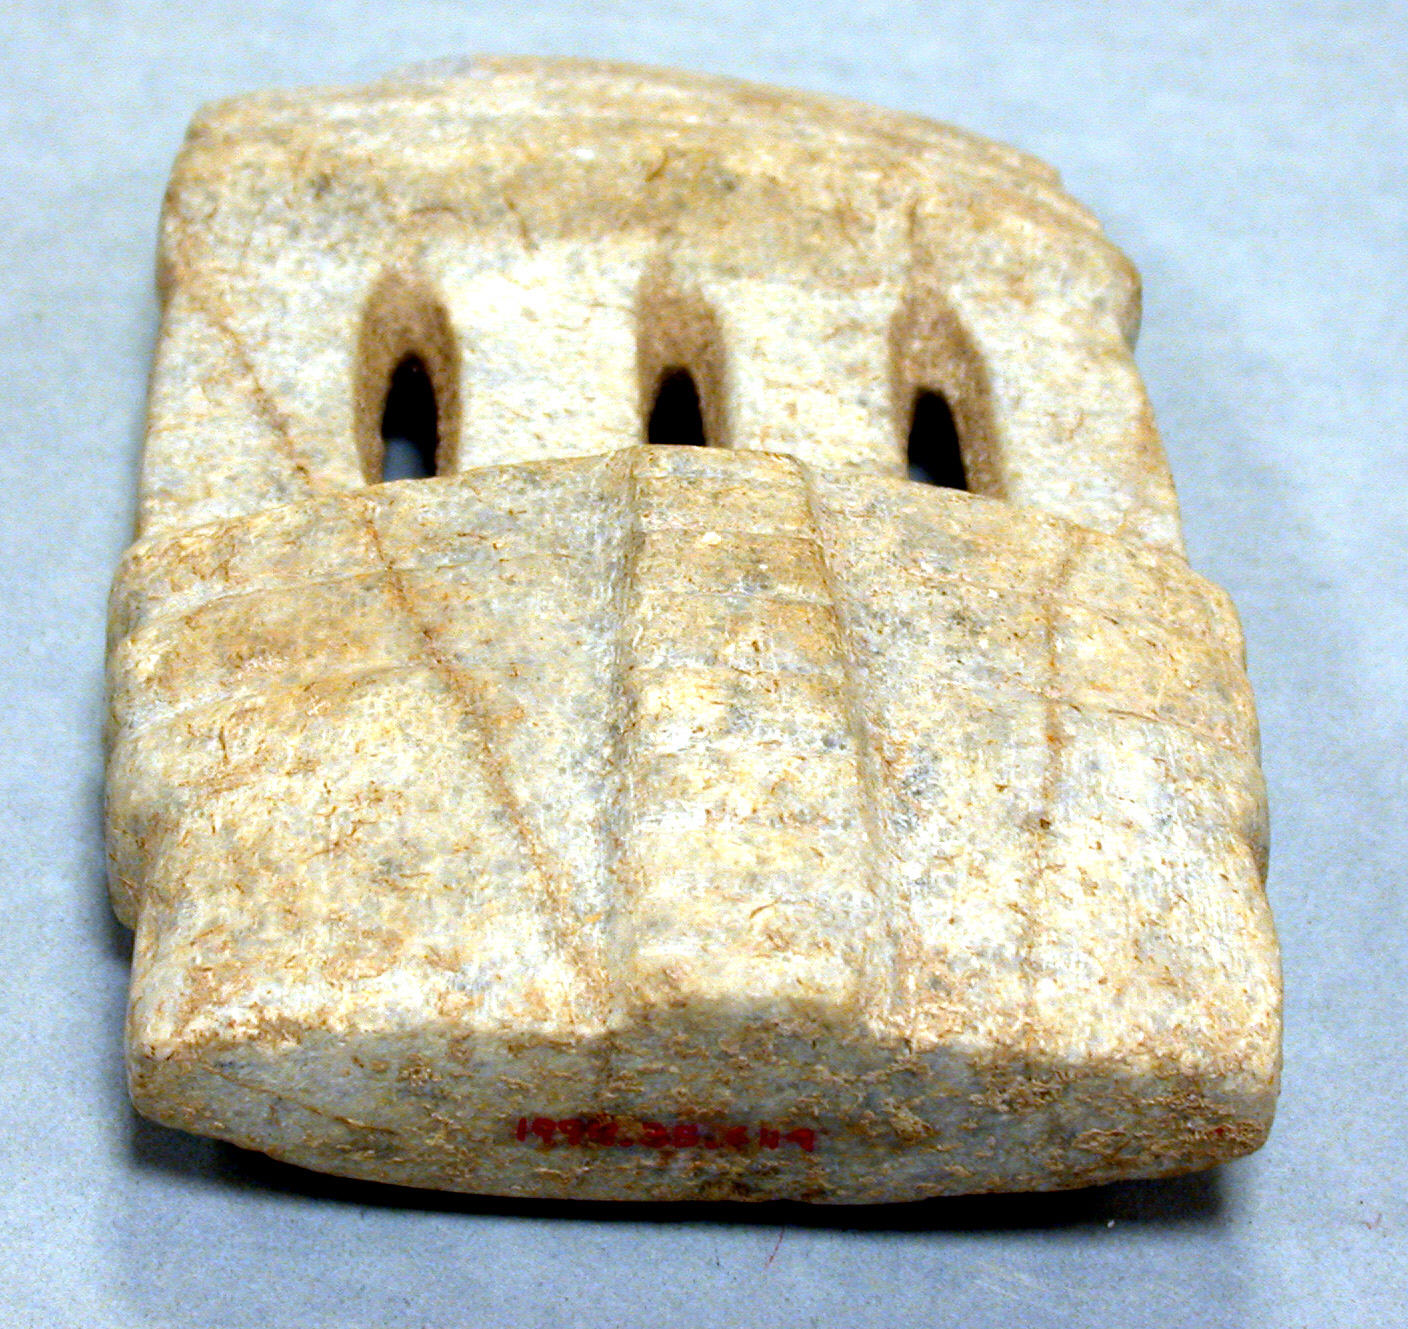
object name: architectural model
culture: mezcala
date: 1-800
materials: stone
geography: mexico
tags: temples